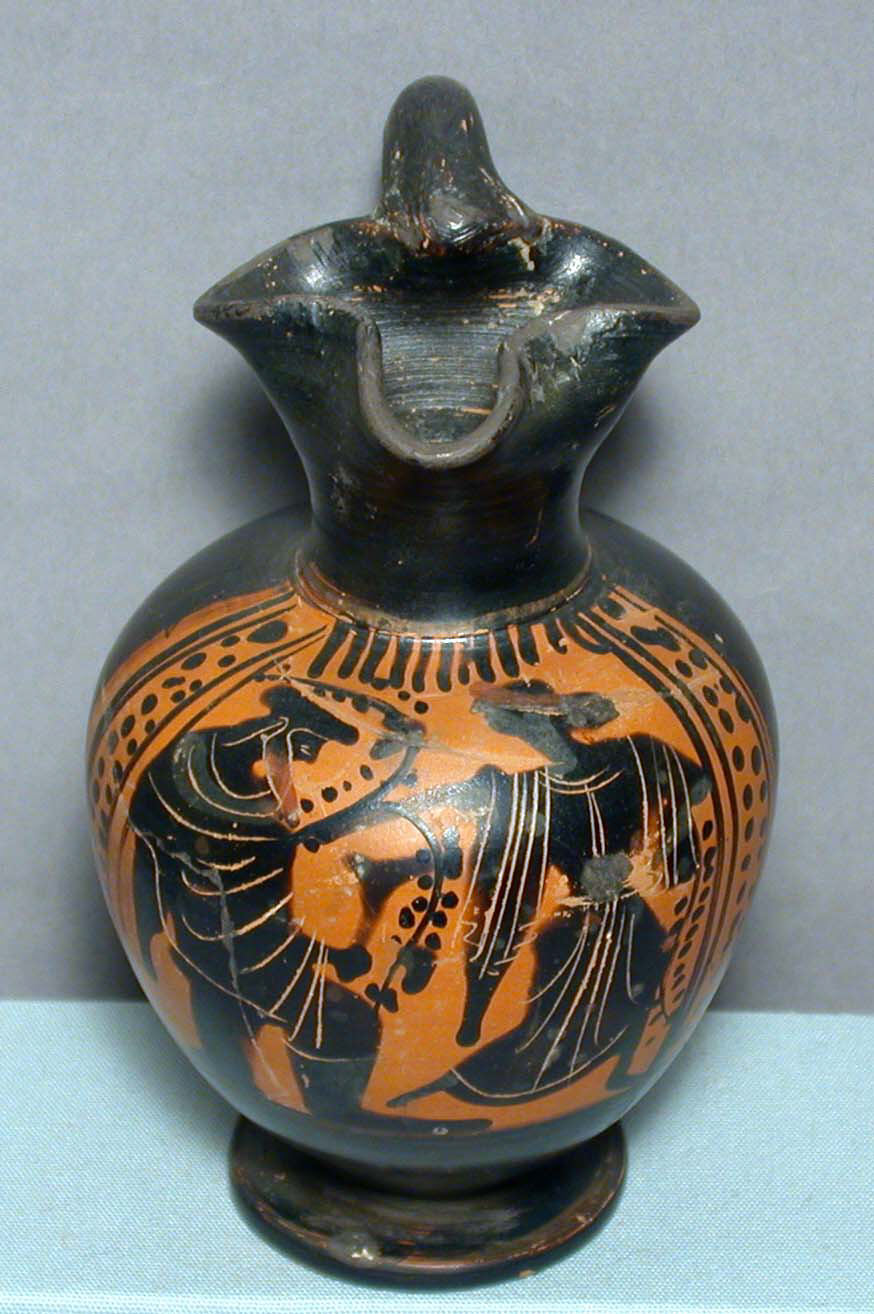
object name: oinochoe with trefoil mouth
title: Terracotta oinochoe with trefoil mouth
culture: greek, attic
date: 534-468 BCE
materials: terracotta